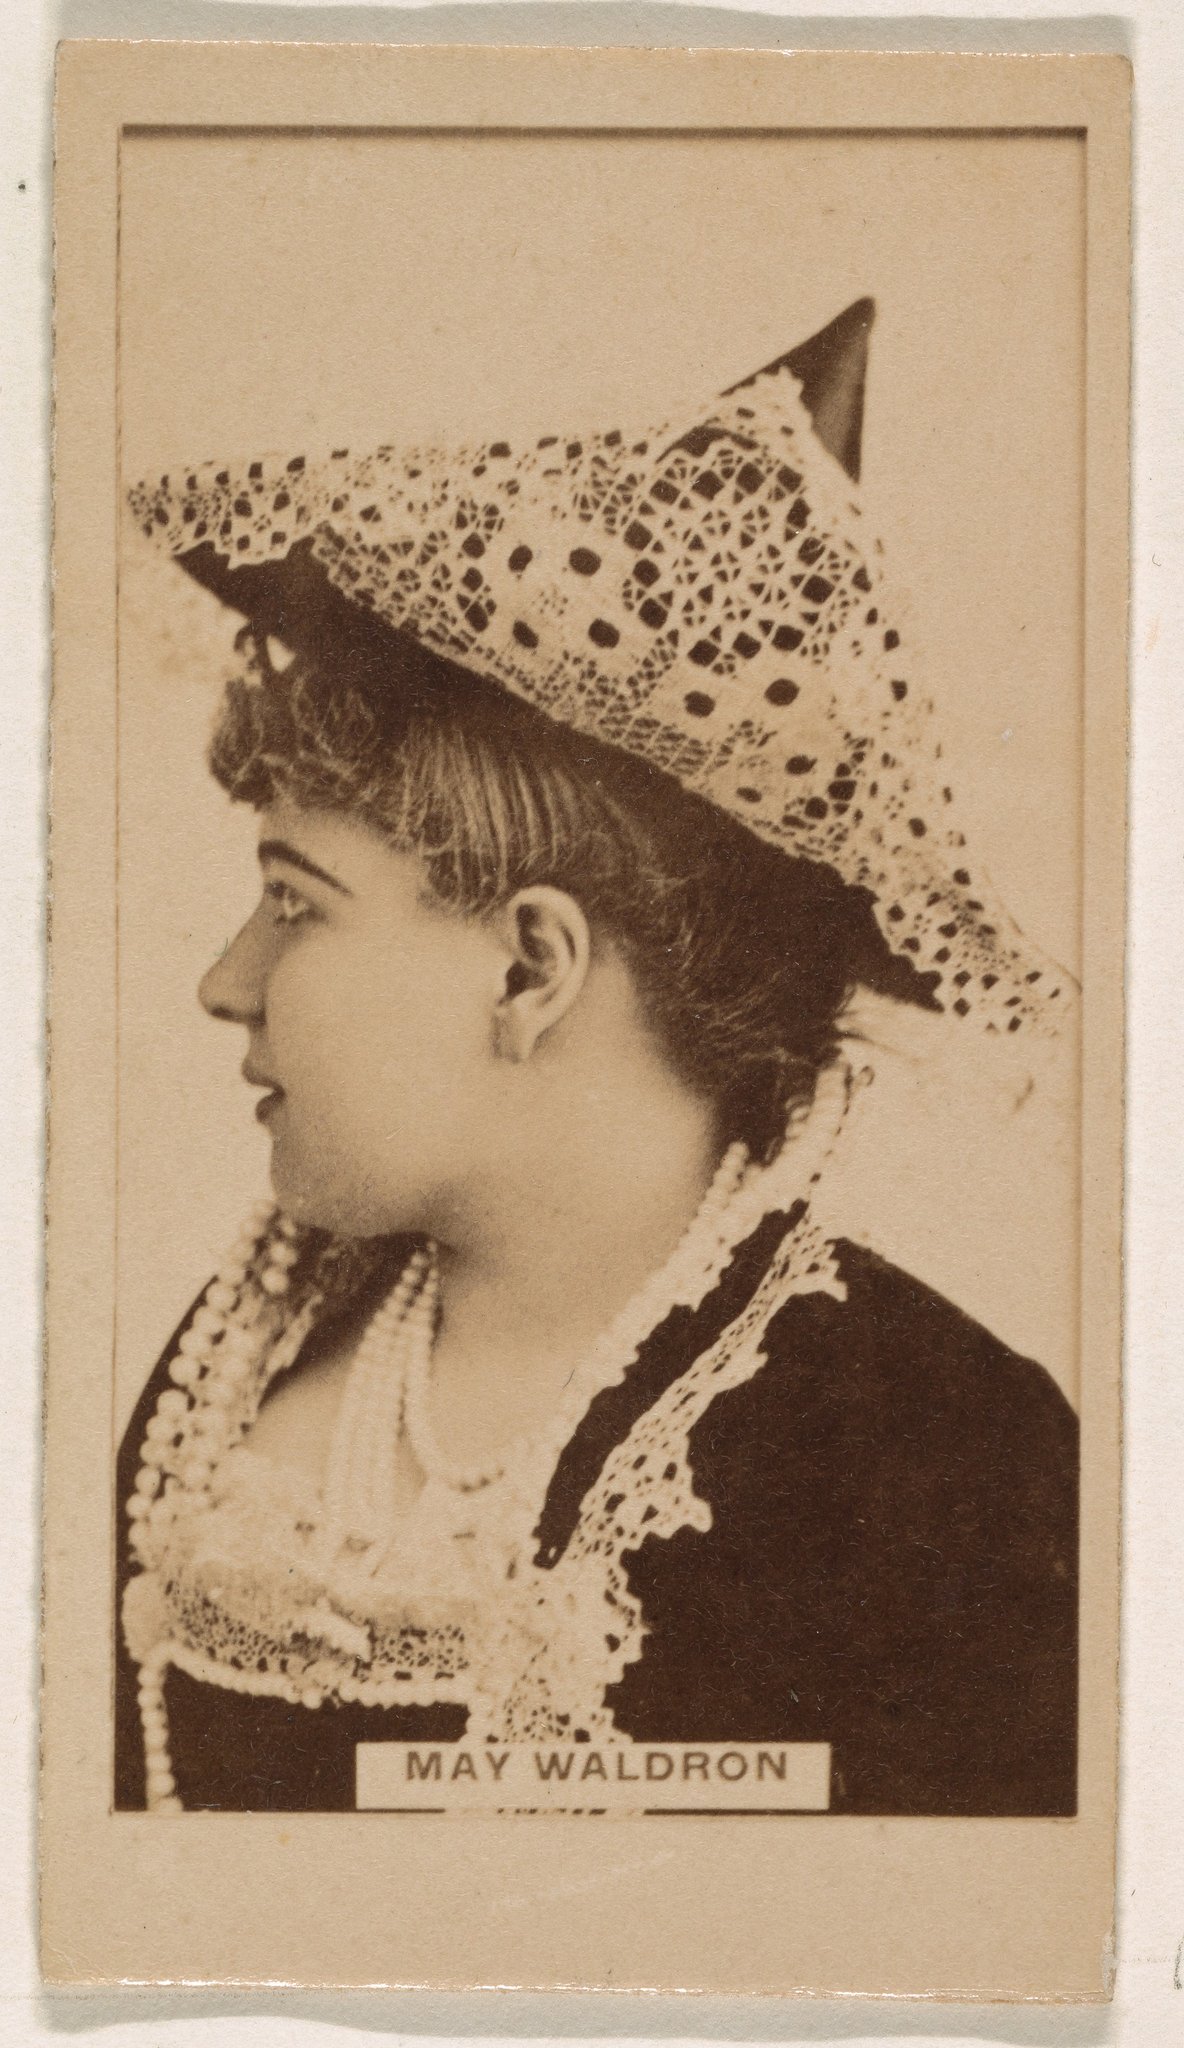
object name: photograph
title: May Waldron, from the Actresses series (N245) issued by Kinney Brothers to promote Sweet Caporal Cigarettes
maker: kinney brothers tobacco company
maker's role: publisher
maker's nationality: american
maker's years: 1869-2011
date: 1890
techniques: albumen silver print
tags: women,actresses